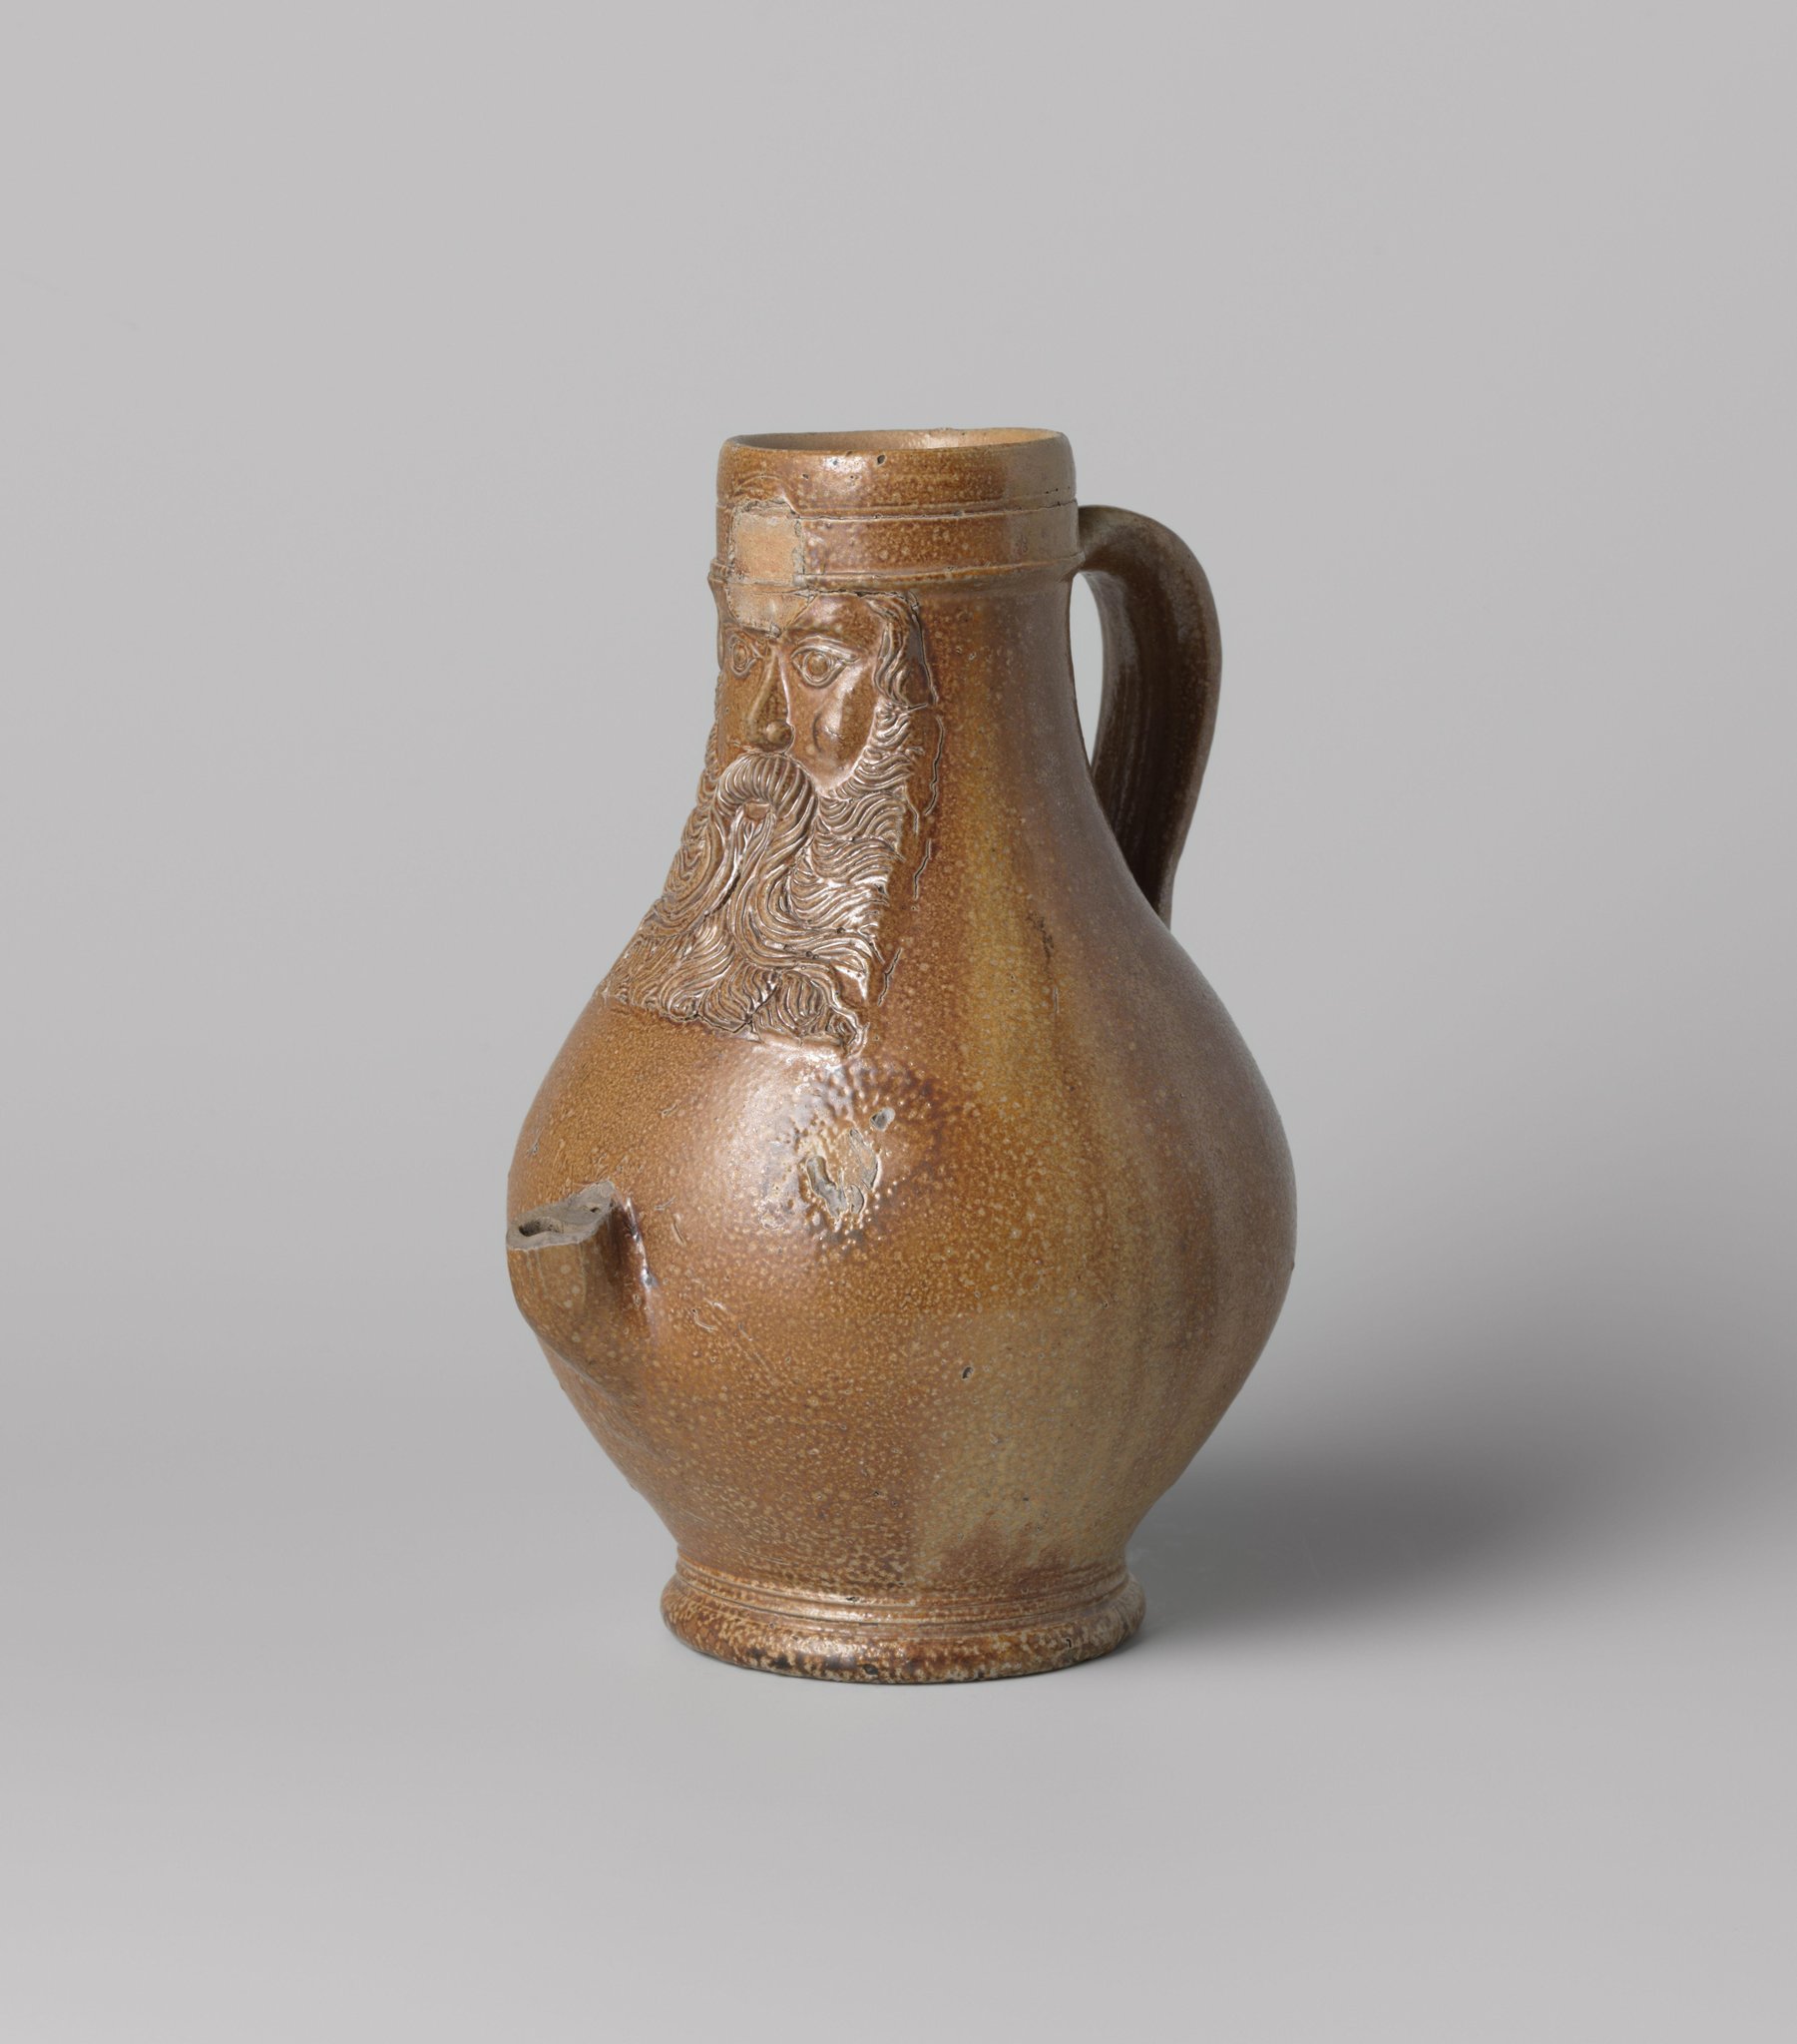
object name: bellarmine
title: Jug (Bartmann jug) with a roundel in a medallion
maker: Anonymous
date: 1540-1570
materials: engobe, glaze, stoneware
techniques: printing, firing, forming, relief, turning, vitrification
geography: cologne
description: Kan (baardmankruik) van steengoed op standring met een peervormig lichaam en wijde nek. Tuit ontbreekt; op de buik het overblijfsel van de aanzet van een lange tuit en op de nek een beschadiging waar de brug was bevestigd. Het C-vormige oor is bevestigd aan de nek en de schouder. Profielen op de nek. Bedekt met een bruine engobe. Op de nek, doorlopend op de schouder, een baardman. Keulen/ Frechen.